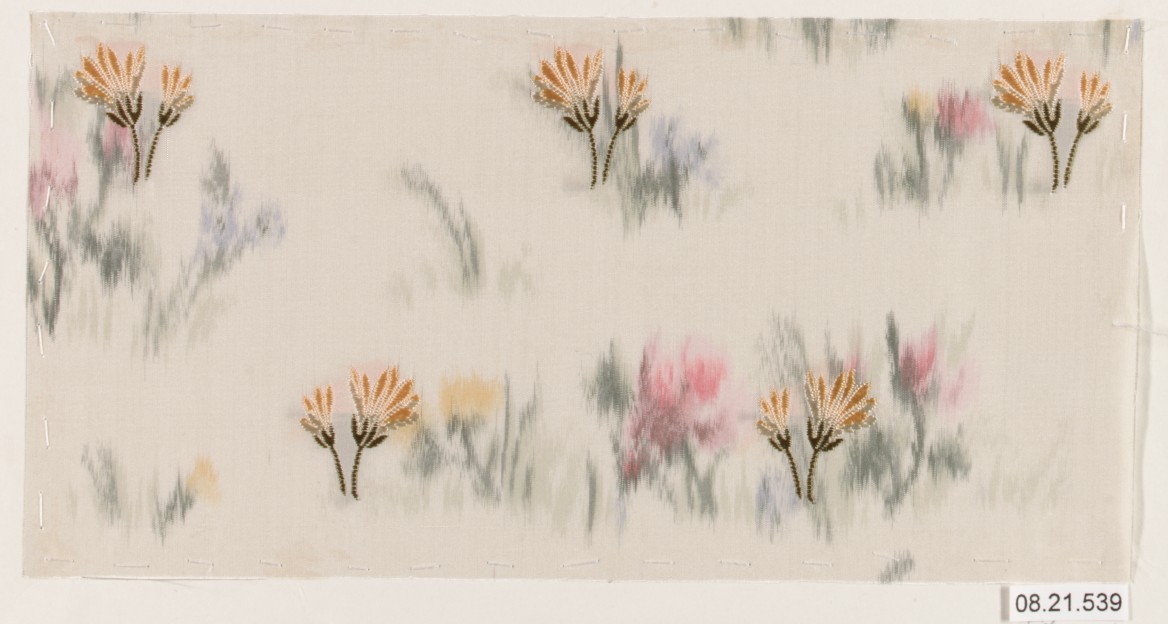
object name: textile sample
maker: Anonymous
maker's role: designer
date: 1900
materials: silk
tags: flowers